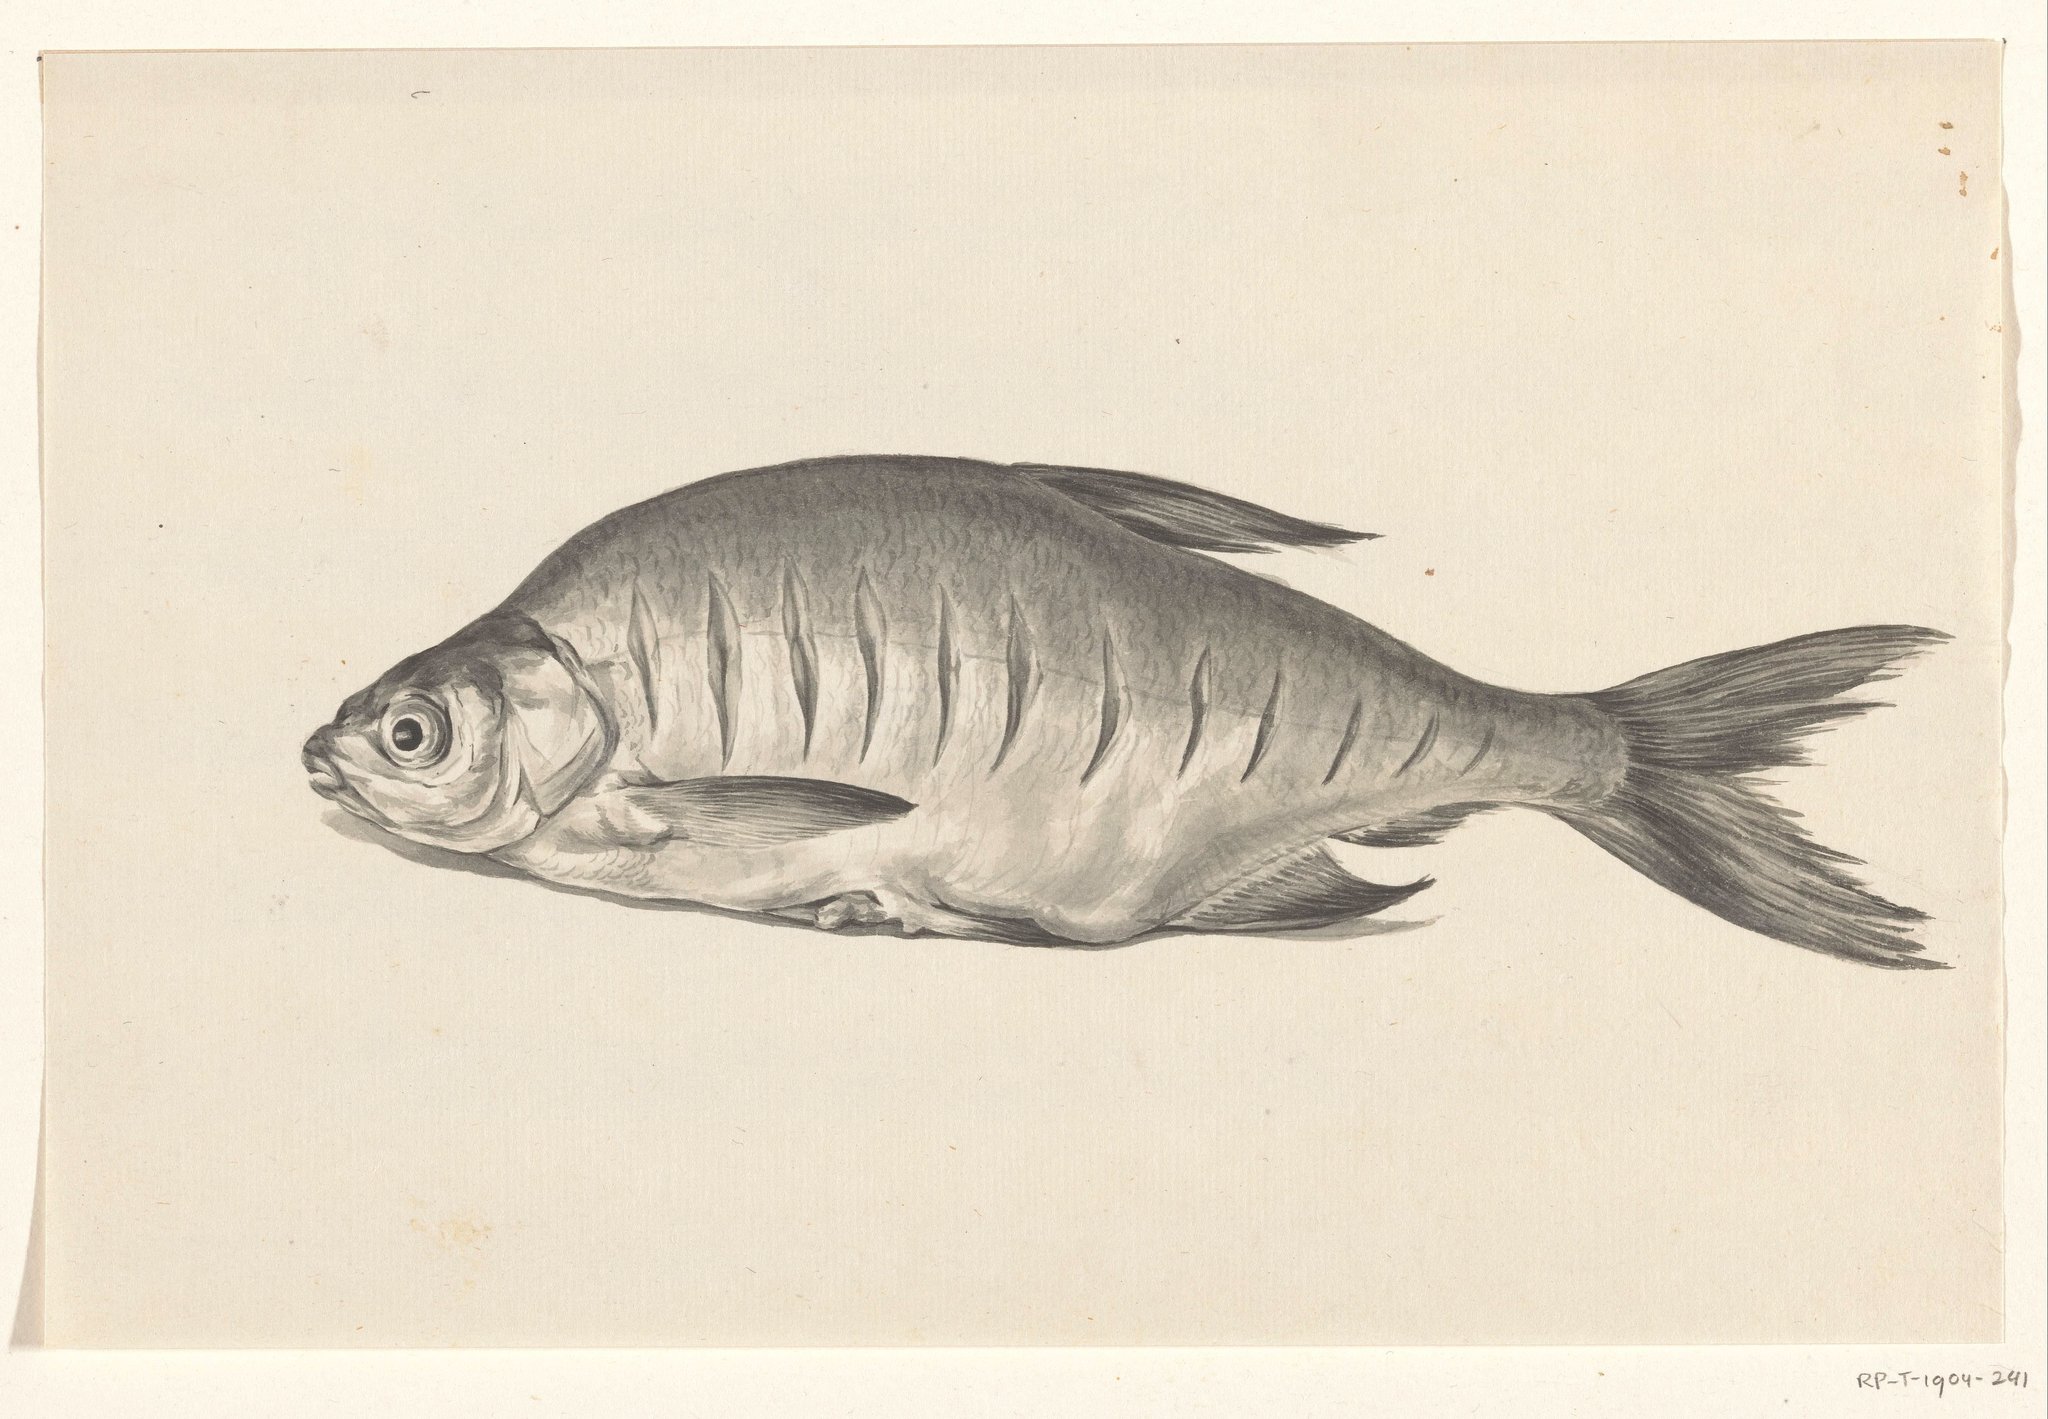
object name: drawing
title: Vis, liggend naar links, met inkepingen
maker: jean bernard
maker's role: draughtsman, print maker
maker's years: 1765-1833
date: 1775-1833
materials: ink, paper, pencil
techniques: brush, pen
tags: bony fishes